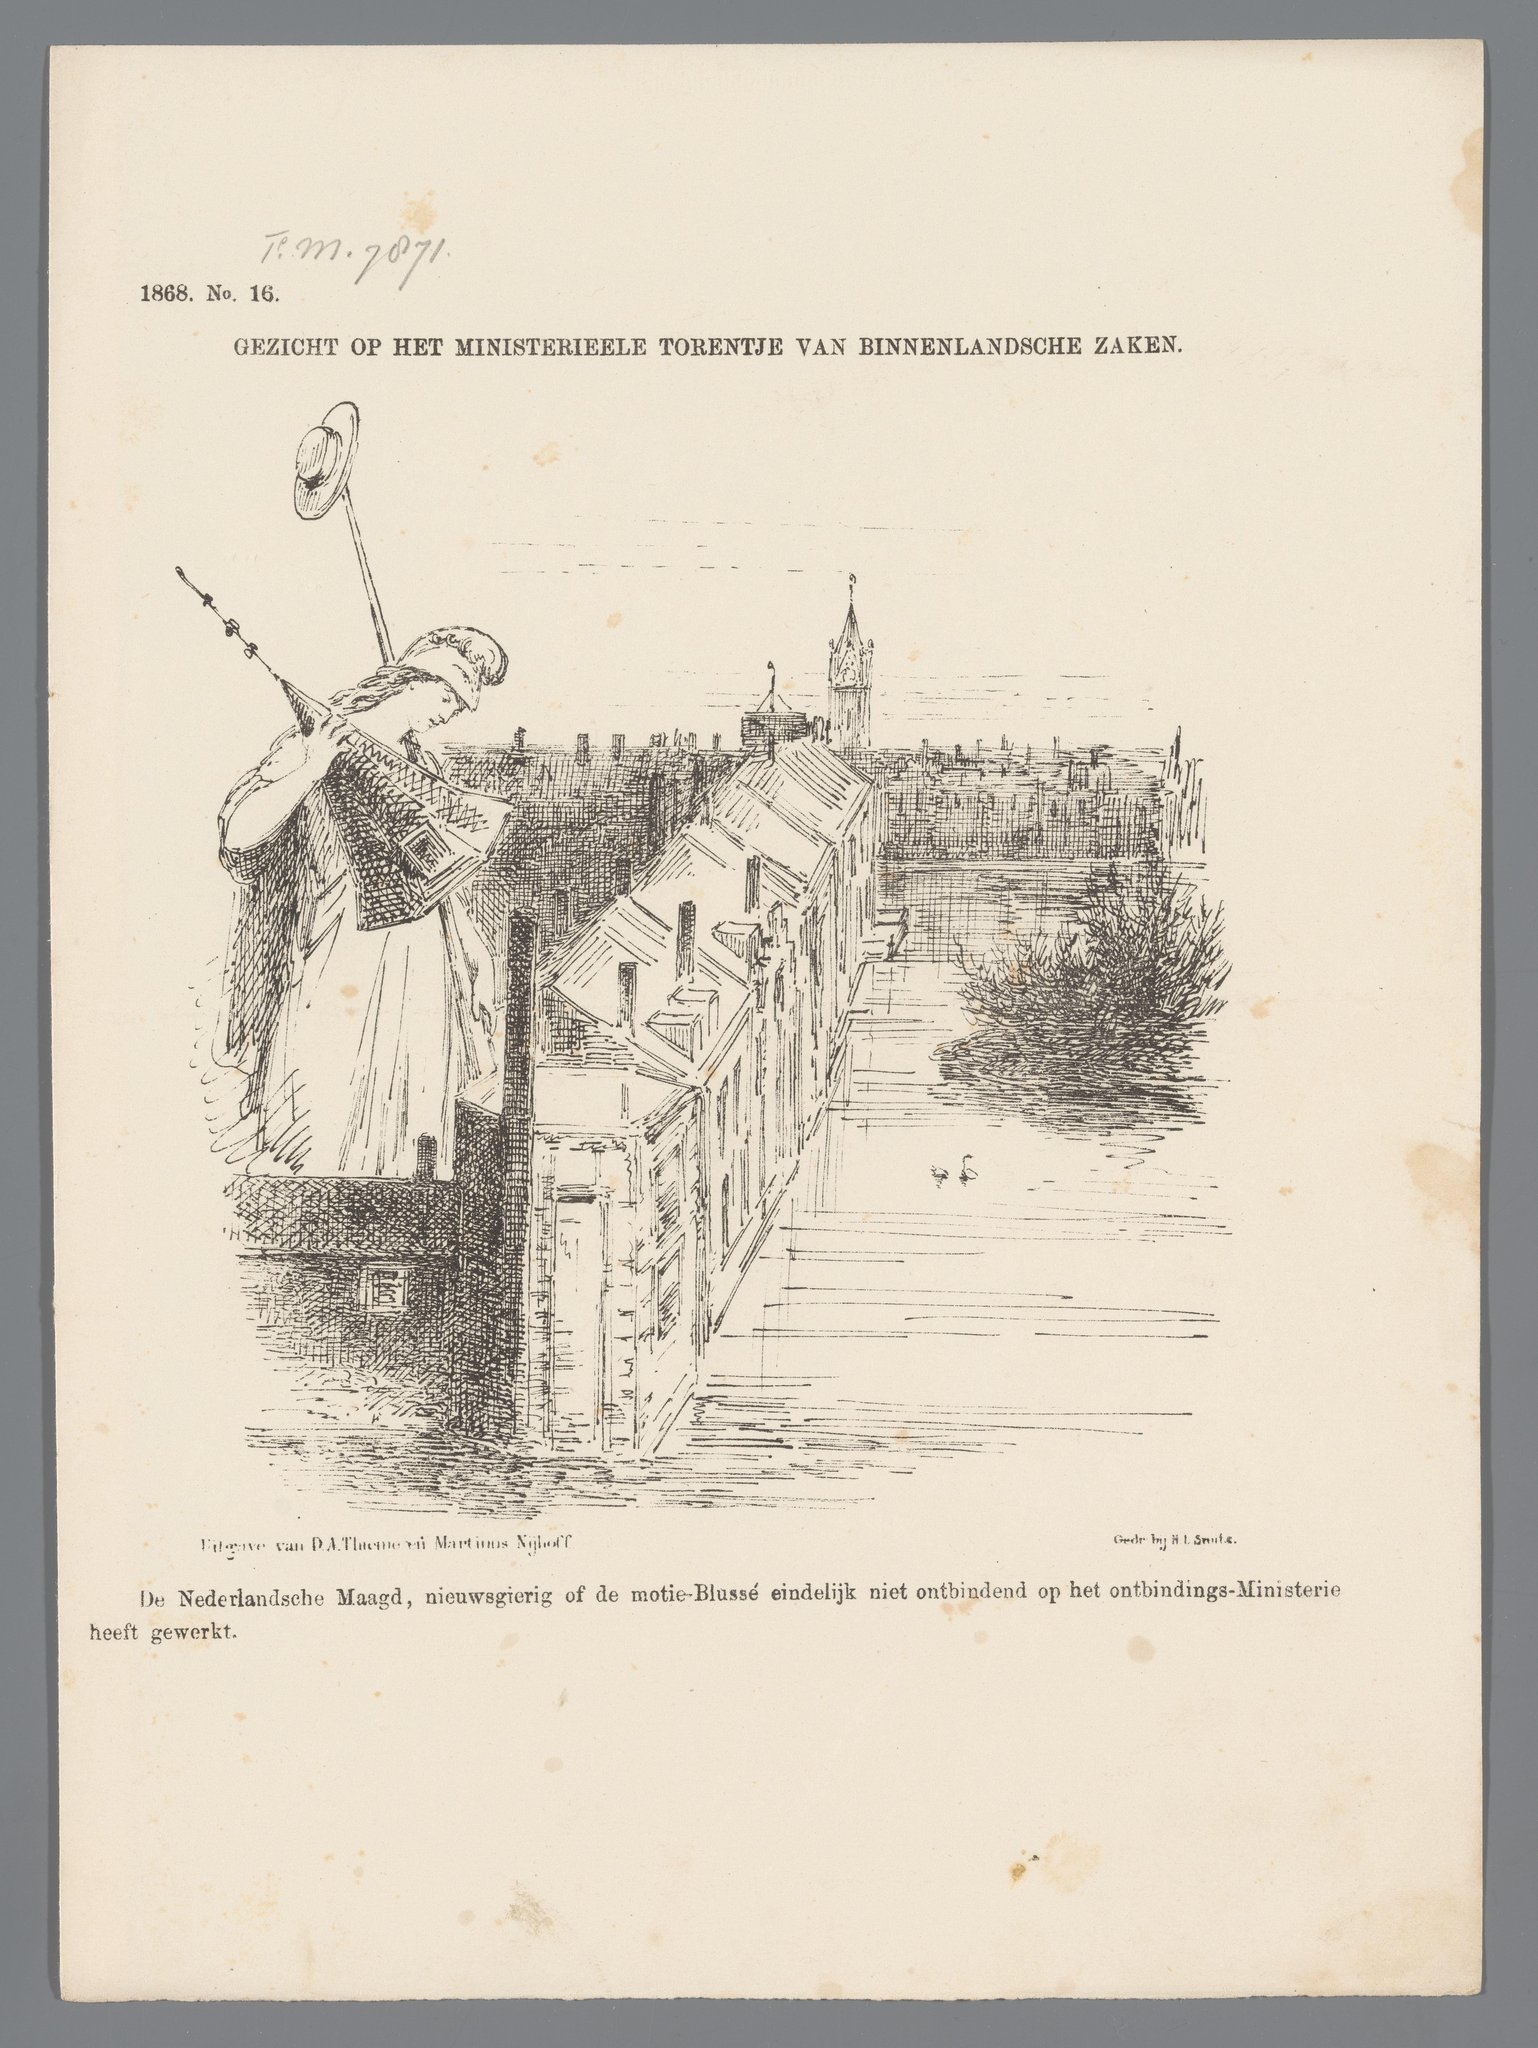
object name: print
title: Spotprent op het Ministerie van Binnenlandse Zaken, 1868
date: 1867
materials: paper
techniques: lithograph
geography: the hague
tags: personifications of countries, nations, states, districts, etc.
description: Spotprent op het Ministerie van Binnenlandse Zaken. De Nederlandse Maagd licht het dak van het Torentje om te zien of het ministerie al ontbonden is. Plaat verschenen bij het weekblad De Nederlandsche Spectator, nr. 16, 18 april 1868.